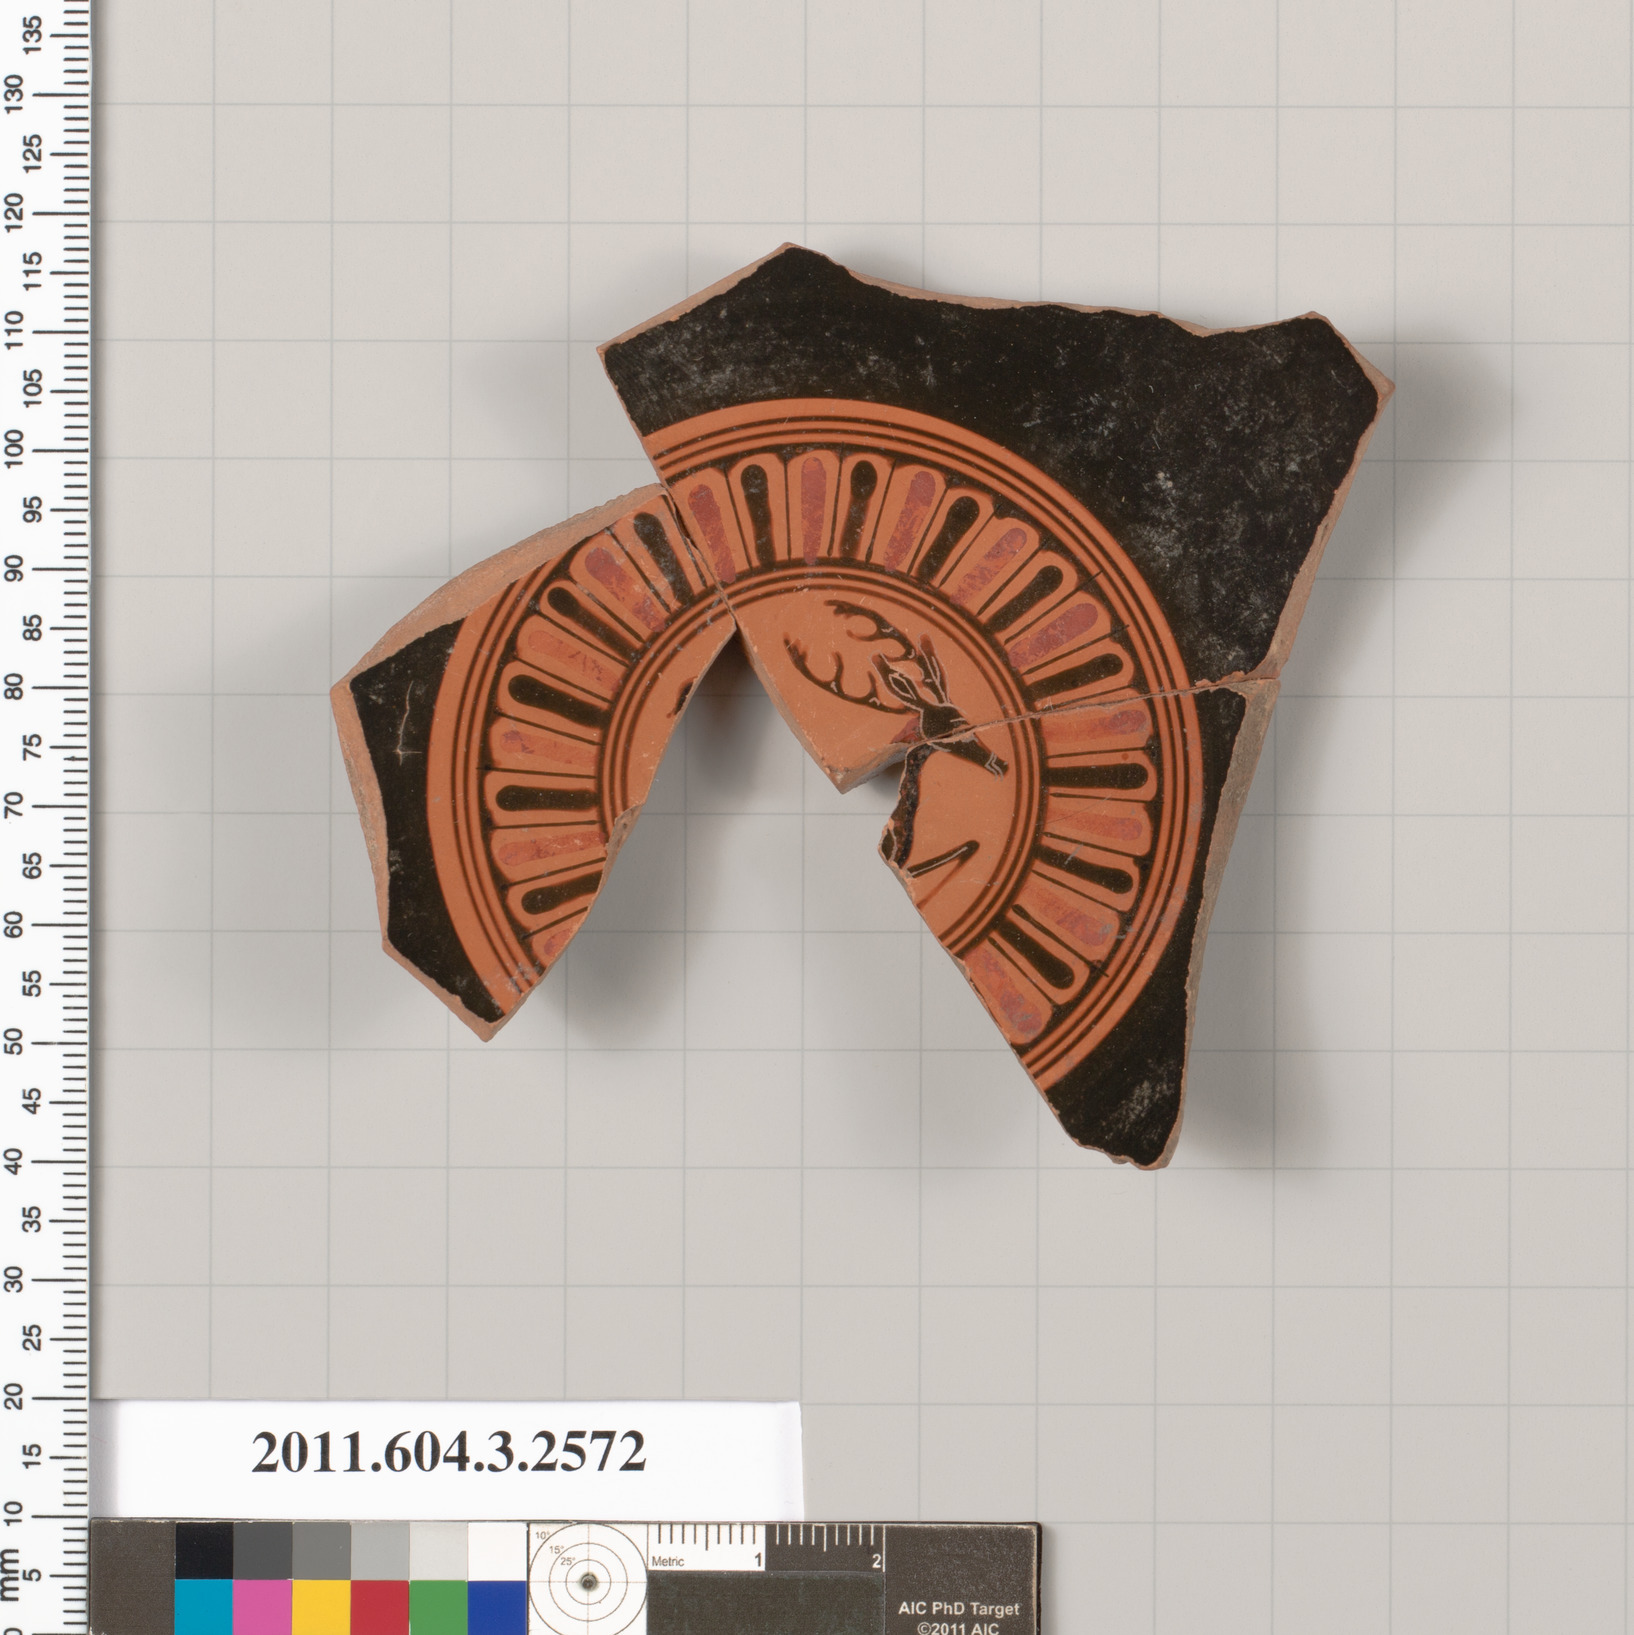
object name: kylix fragment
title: Terracotta fragment of a Little Master cup (drinking cup)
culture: greek, attic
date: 575-551 BCE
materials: terracotta